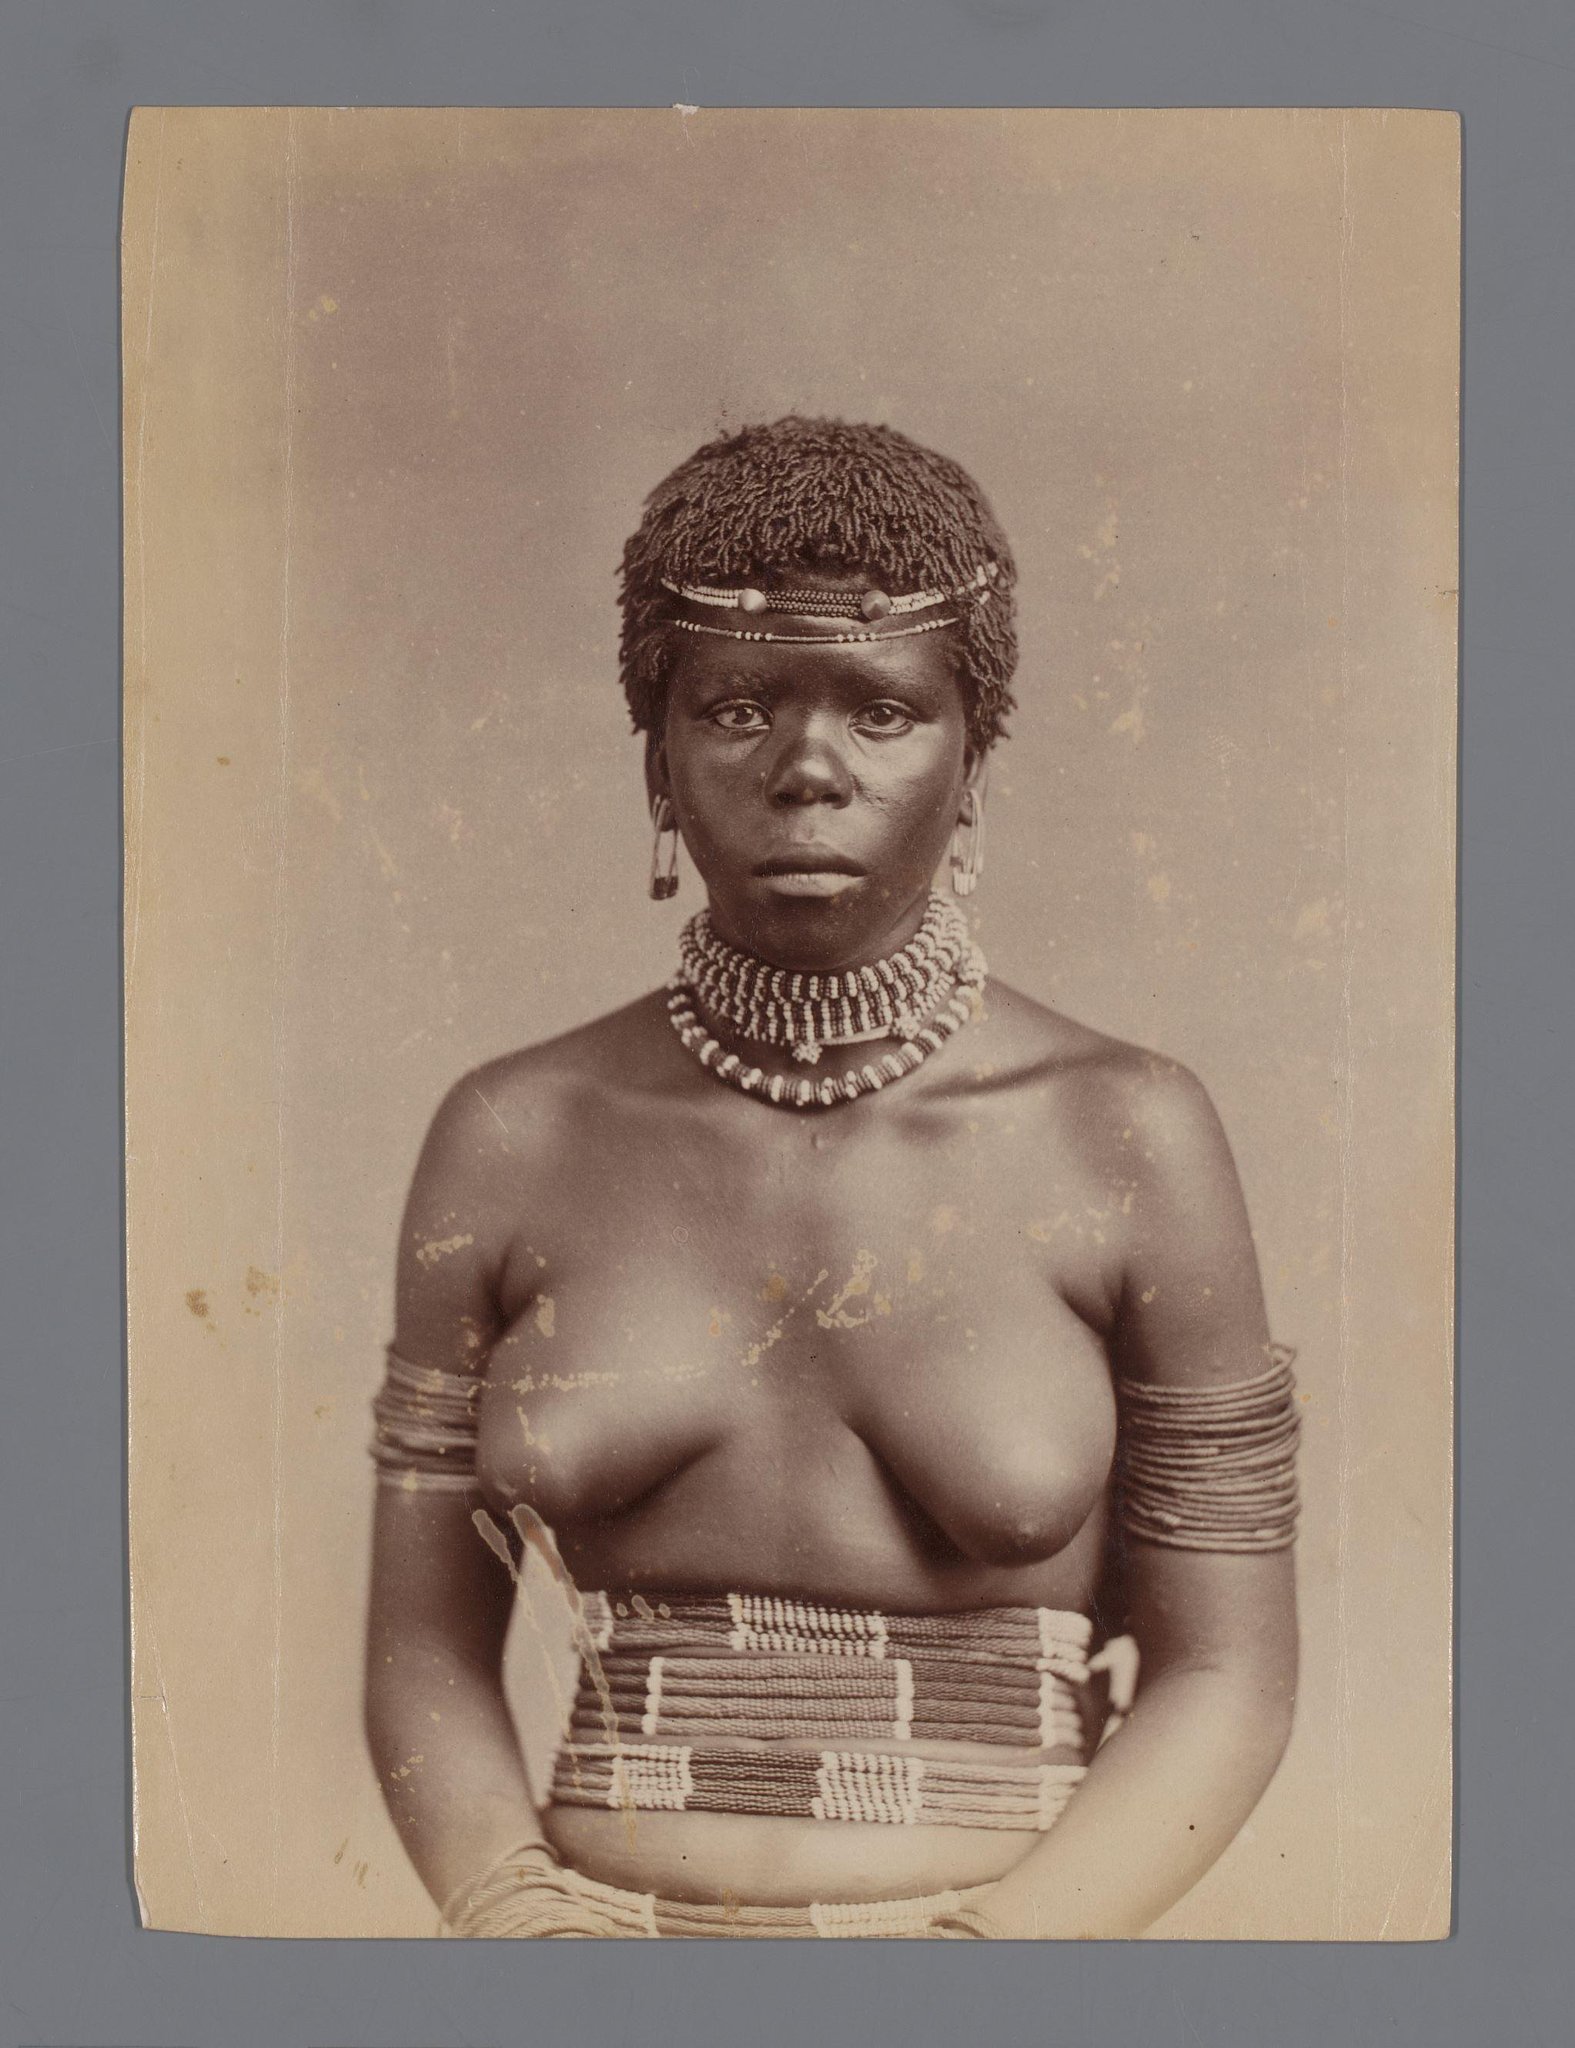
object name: photograph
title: Portret van een vrouw, Afrika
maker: Anonymous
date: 1880-1900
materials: paper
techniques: albumen print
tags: afrika